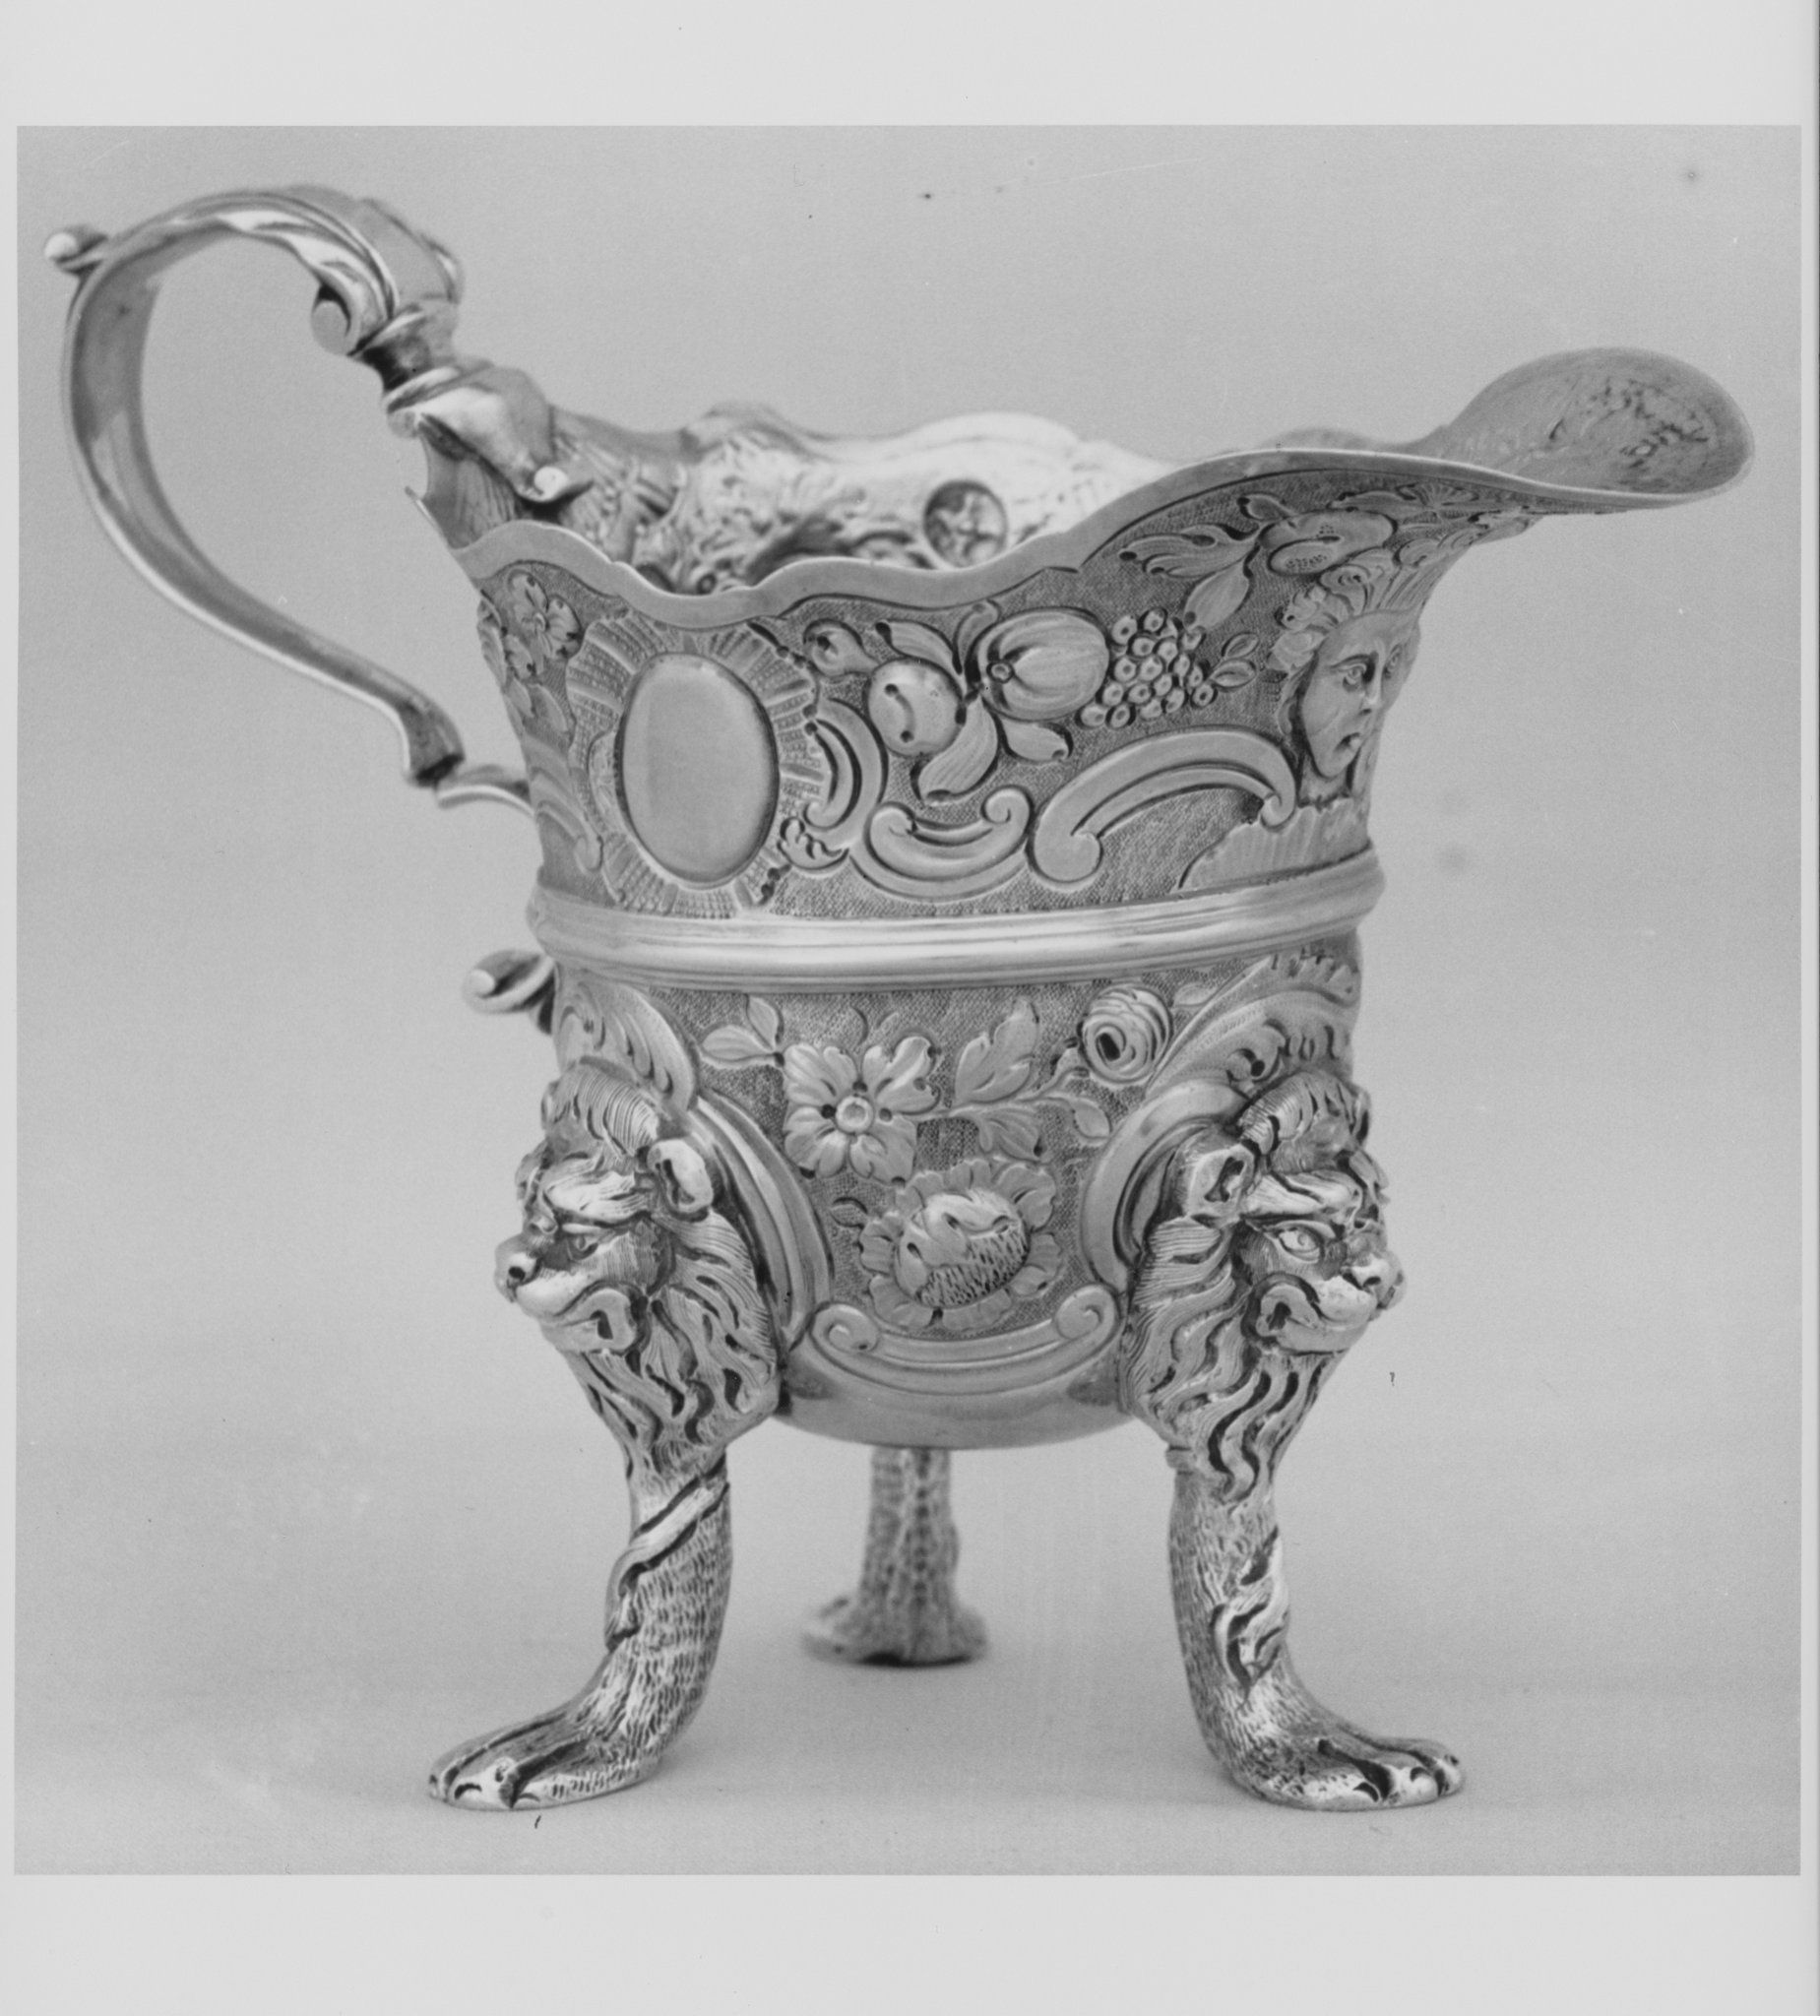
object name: cream jug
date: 1760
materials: silver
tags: fruit,lions,flowers